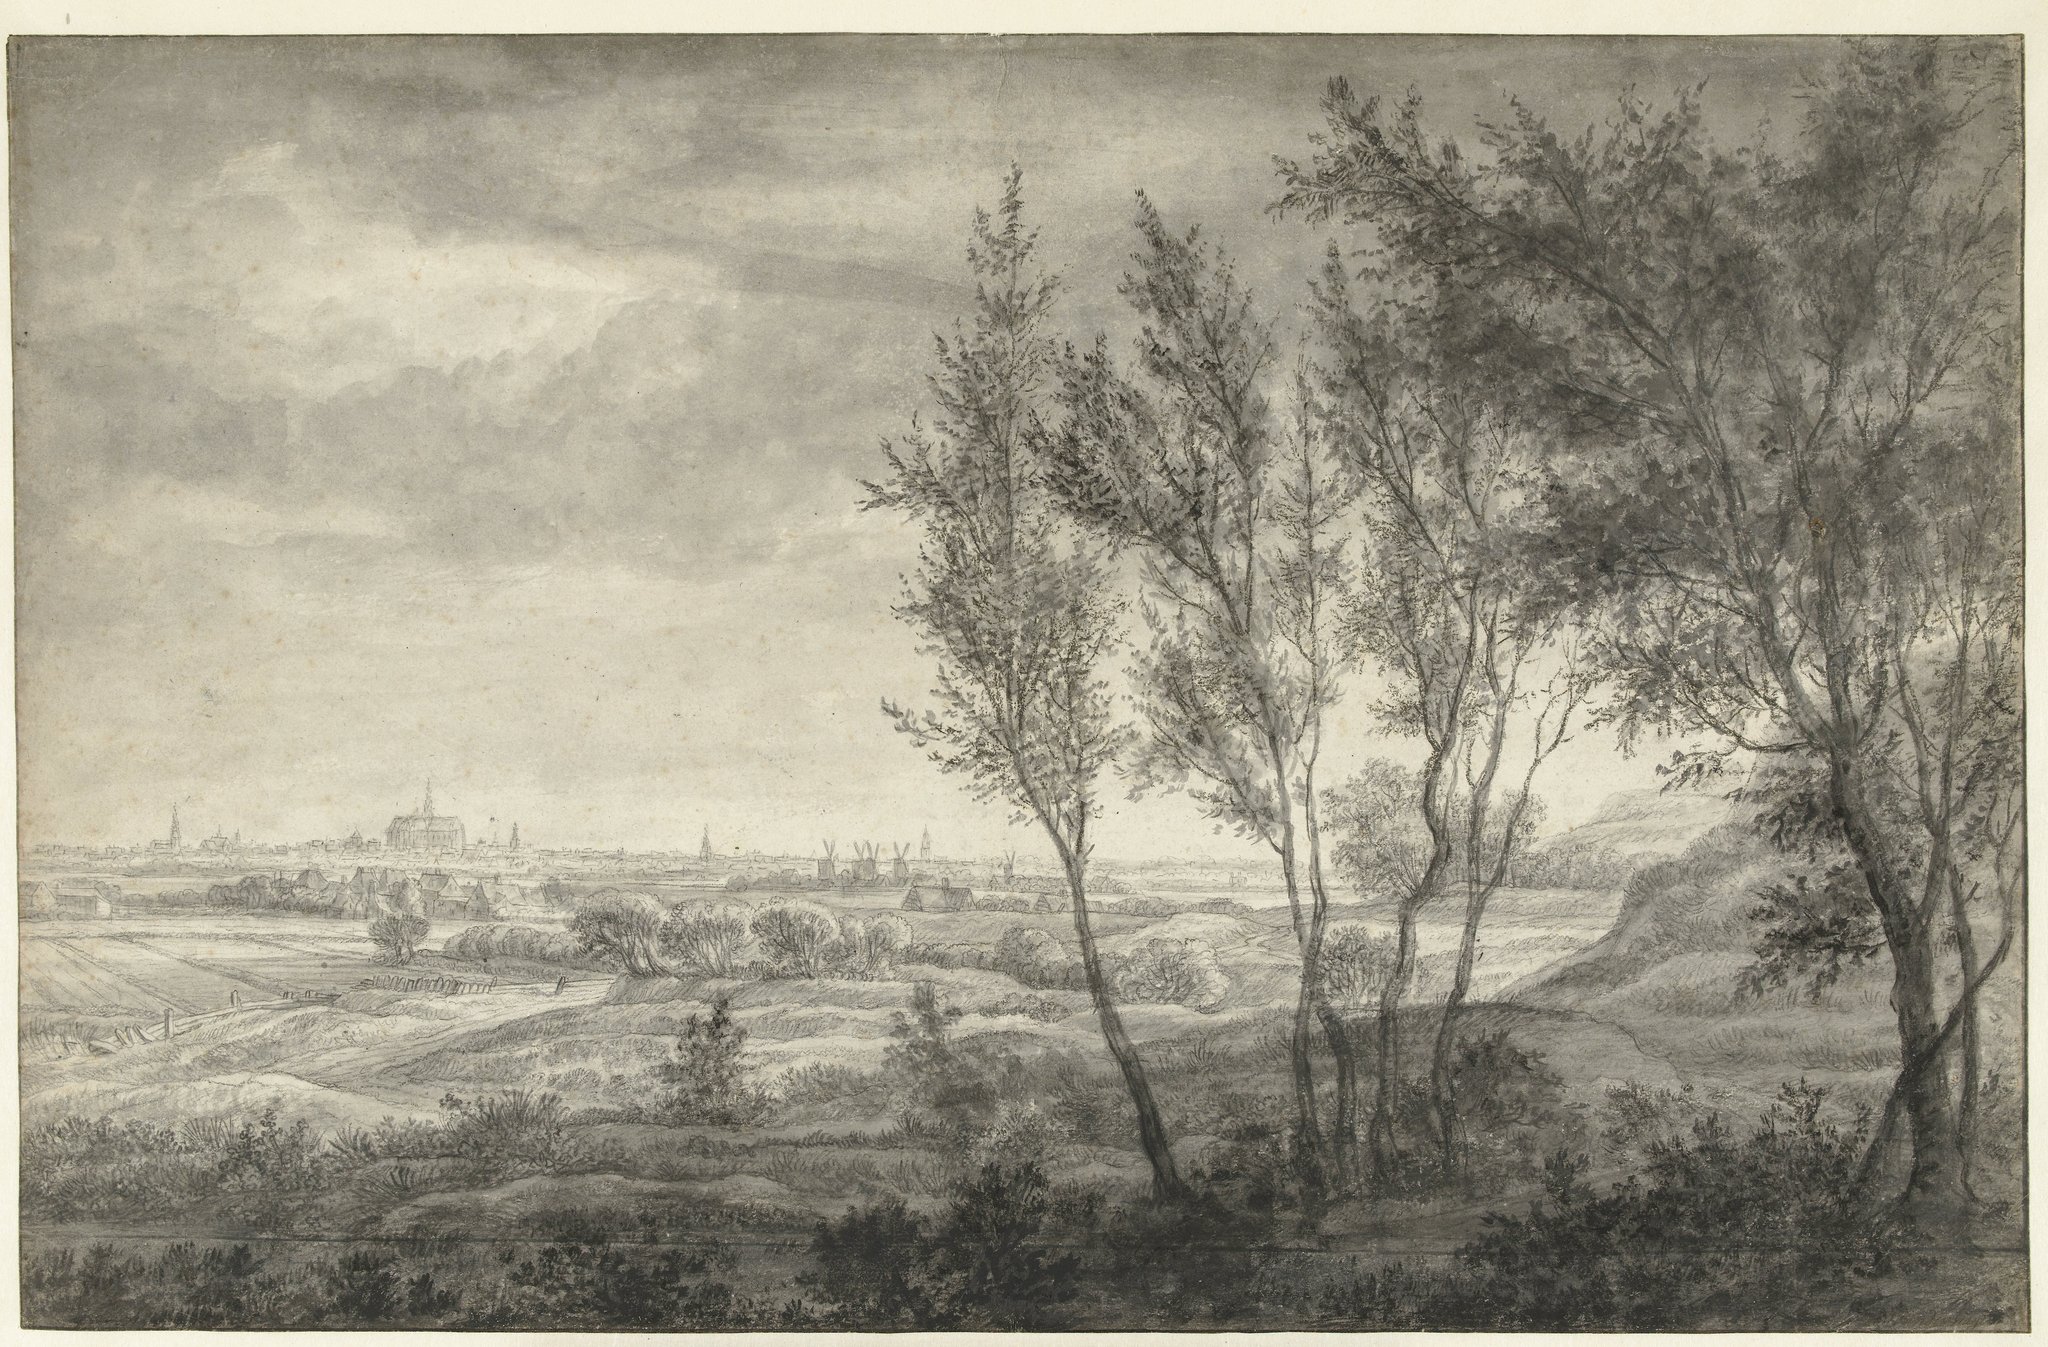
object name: drawing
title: Gezicht vanuit de duinen op Haarlem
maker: anthonie waterloo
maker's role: draughtsman, painter, print maker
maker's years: 1609-1690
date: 1619-1690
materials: chalk, charcoal, paper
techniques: brush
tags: dunes (sea not visible); in the dunes, prospect of city, town panorama, silhouette of city, haarlem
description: Pendant van 'Gezicht vanuit de duinen op Haarlem met ruïne van het Huis te Kleef', inventarisnummer RP-T-1905-18A.